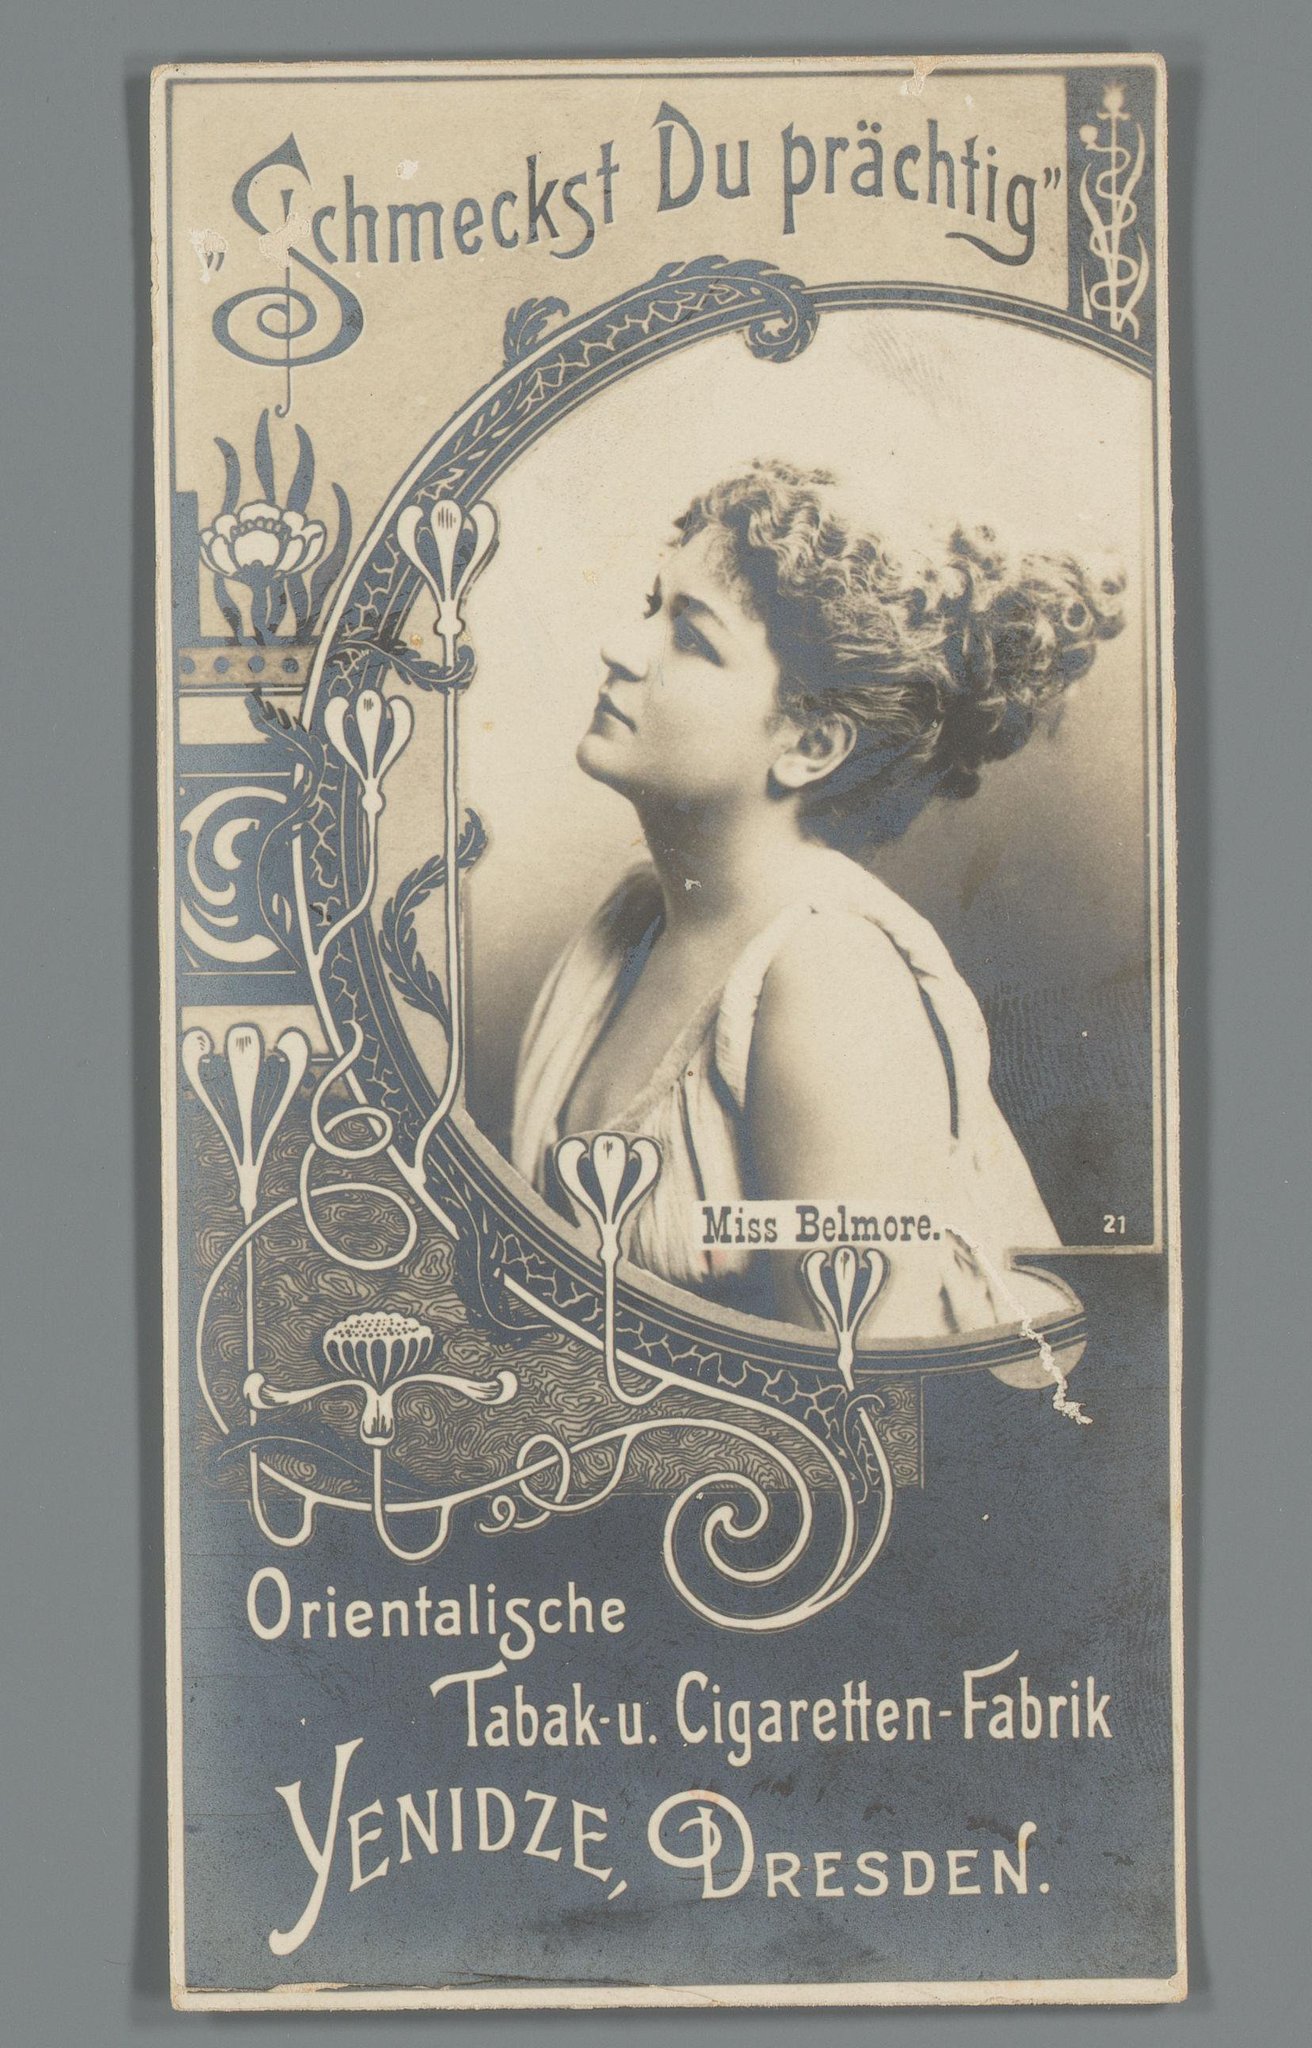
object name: photograph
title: Reclame voor tabak van Yenidze in Dresden met portret van Daisy Belmore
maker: Anonymous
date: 1890-1915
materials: paper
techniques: gelatin silver print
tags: london, advertising, historical persons - bb - woman, tobacco